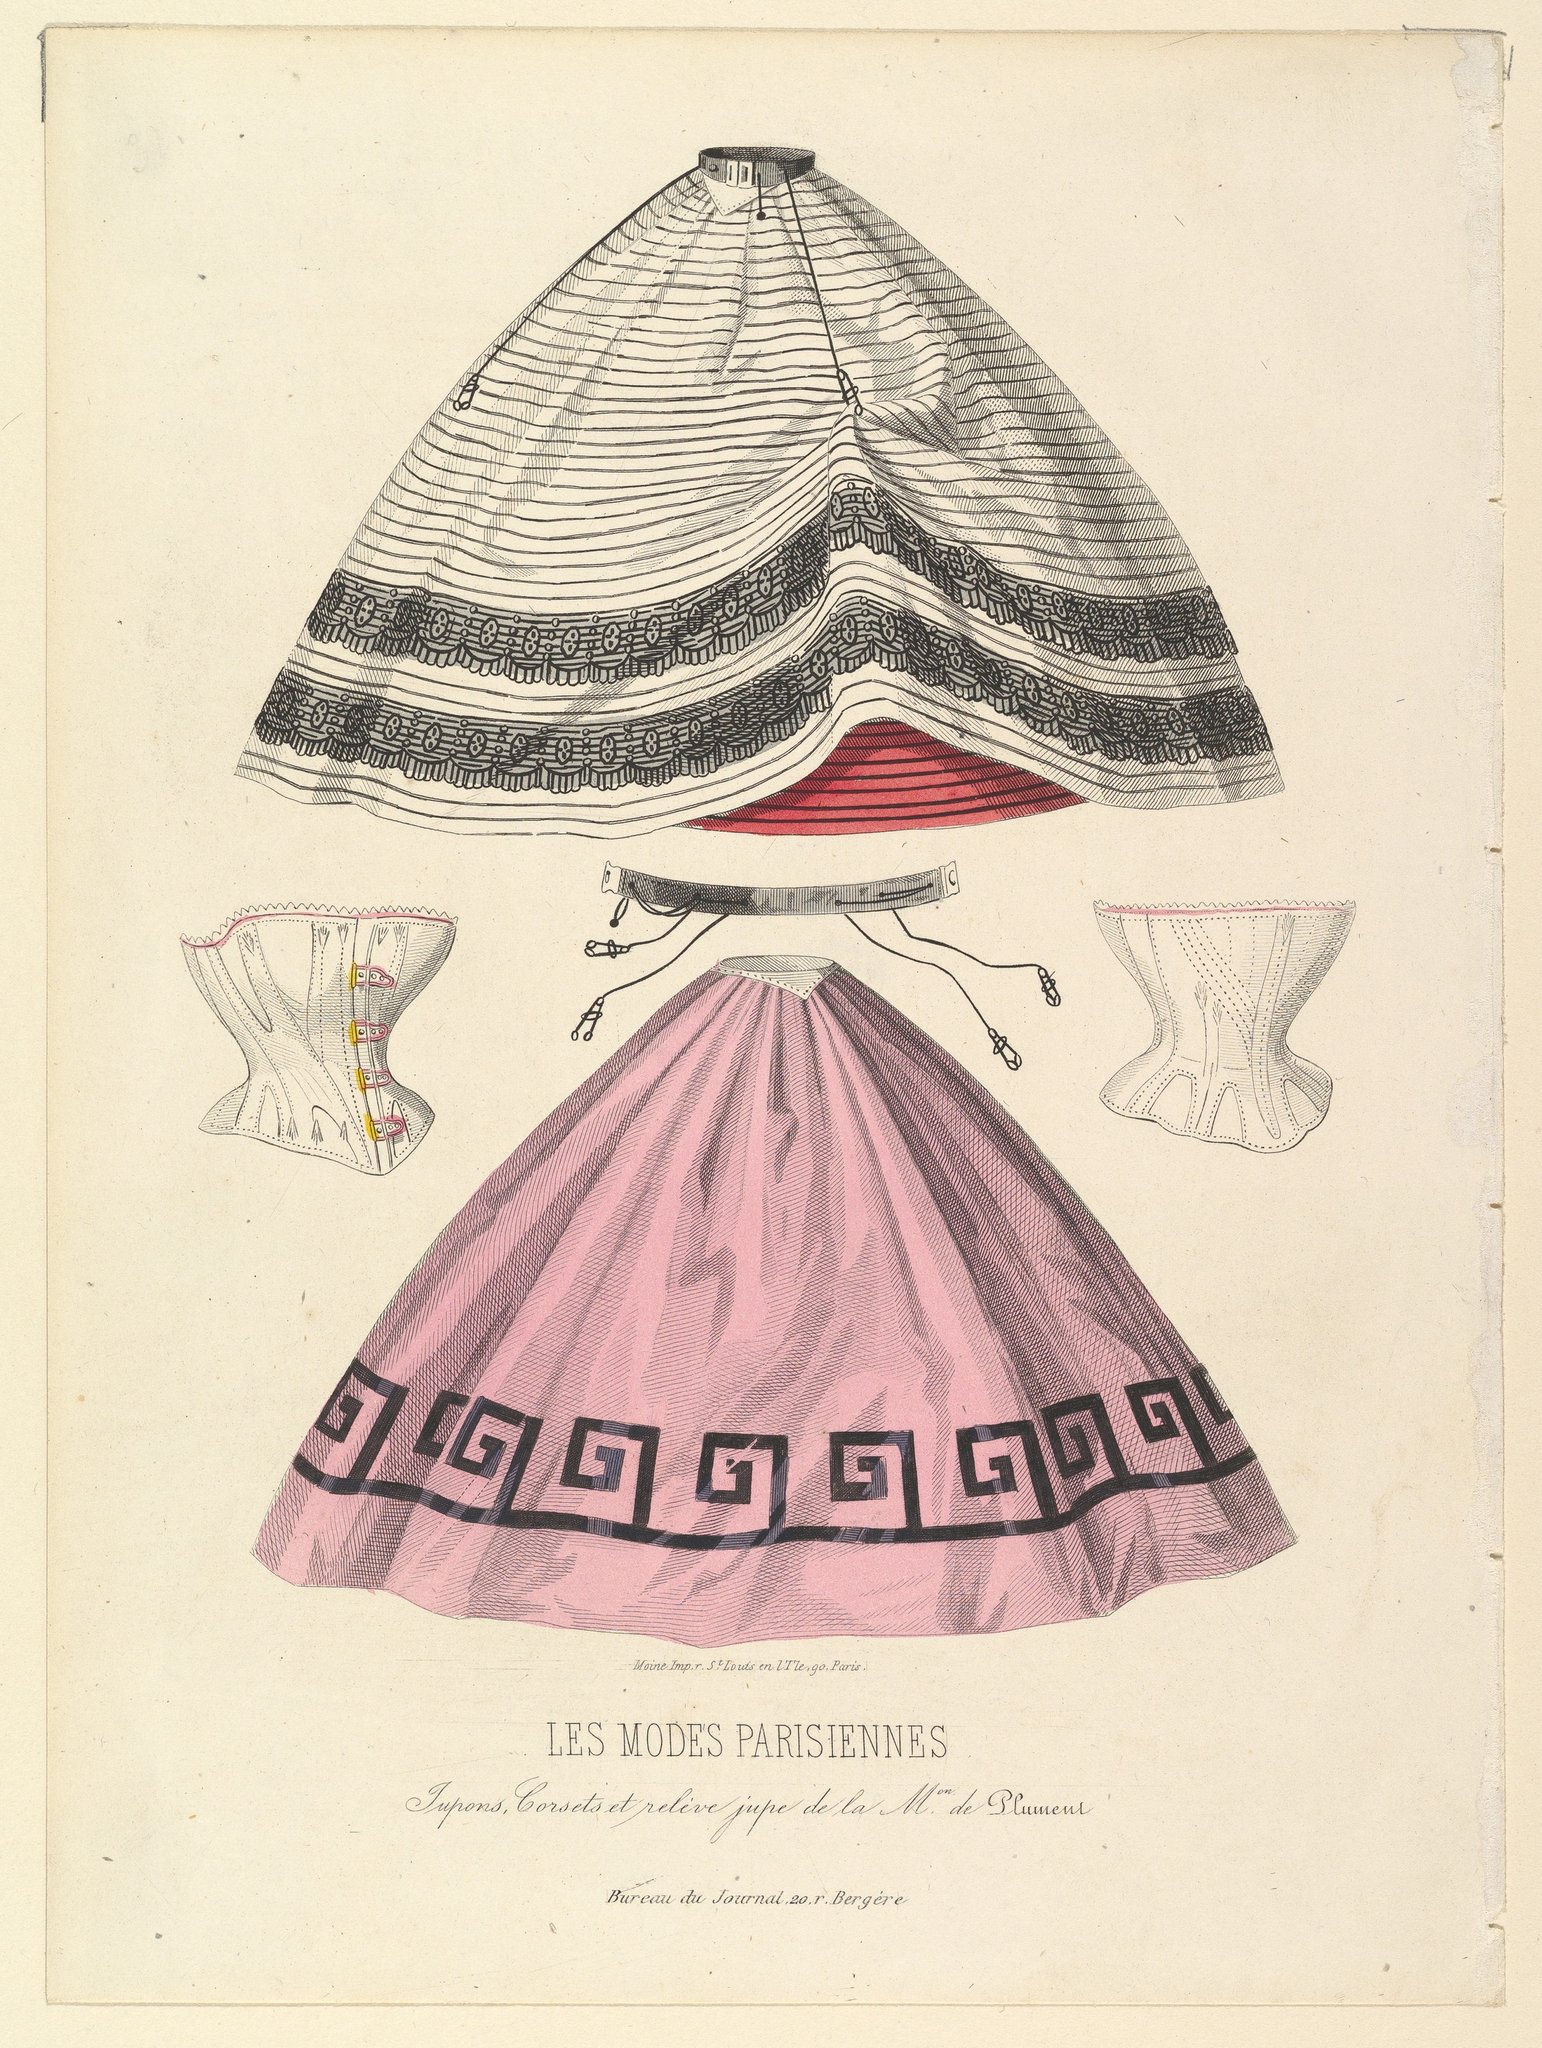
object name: print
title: Jupons, corsets et relève jupe de la Maison de Plument, from Les Modes Parisiennes Illustrées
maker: anonymous, french, 19th century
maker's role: artist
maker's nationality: french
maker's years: 1800-1900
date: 1862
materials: steel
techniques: engraving, hand coloring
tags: corsets